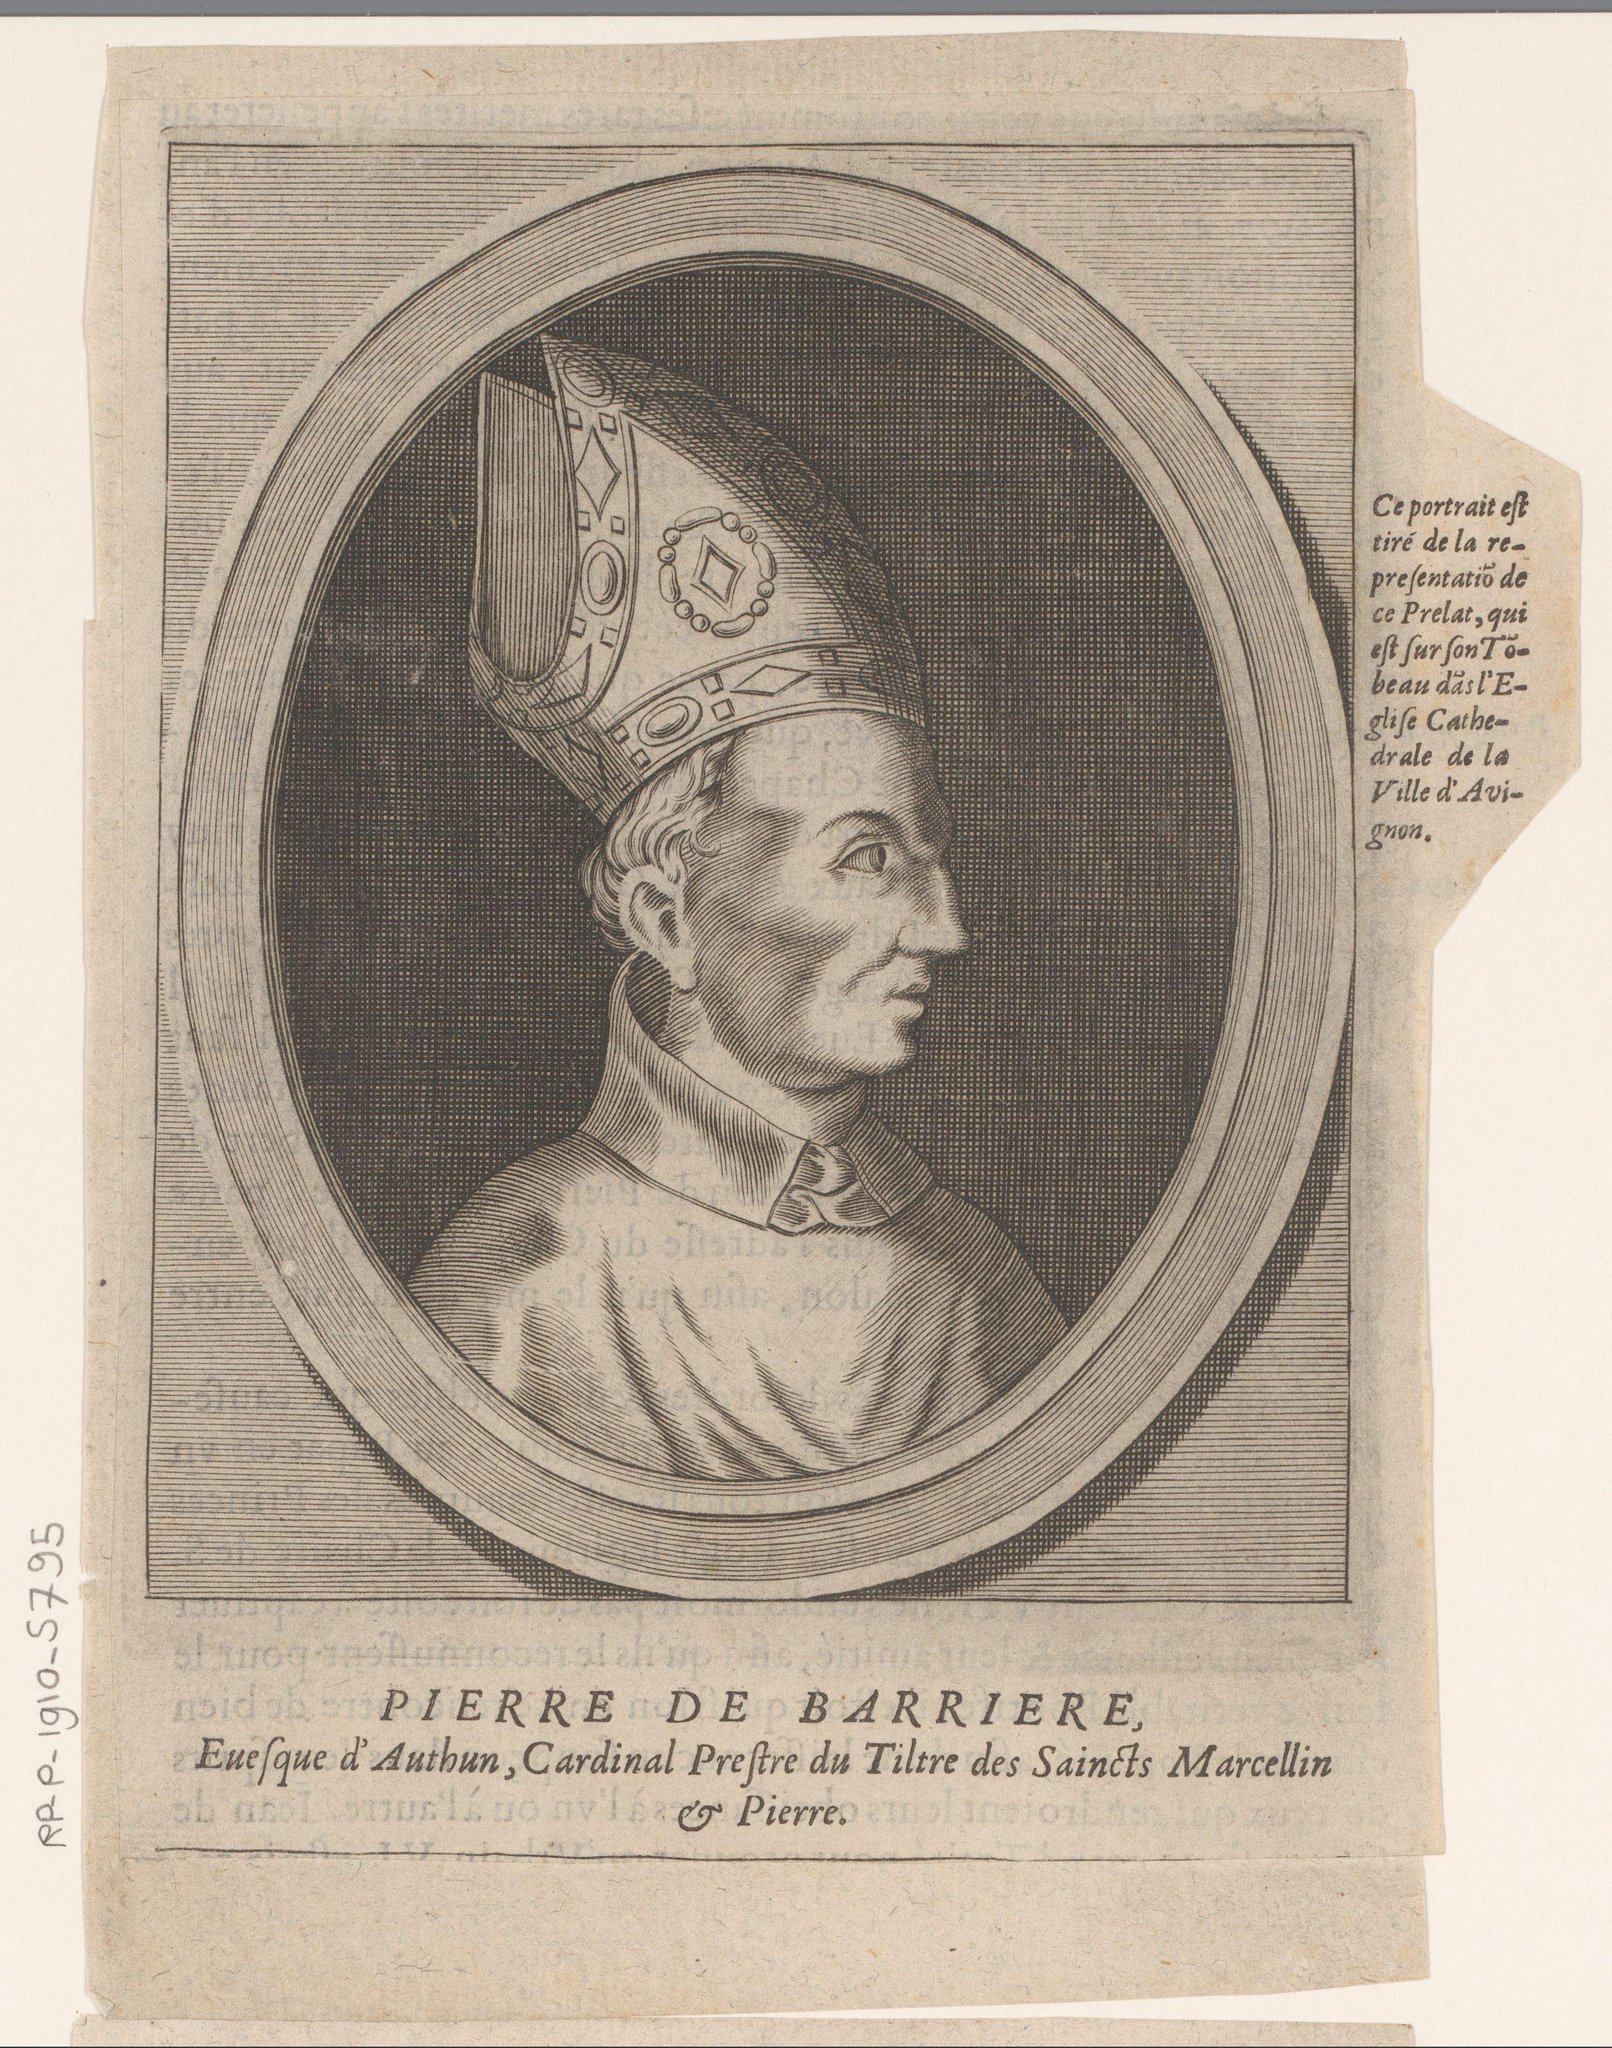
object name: book illustration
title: Pierre de Barriere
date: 1660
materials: paper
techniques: engraving, etching, letterpress printing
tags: archbishop, bishop, etc. (roman catholic), historical persons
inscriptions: collector's mark: Lugt 2228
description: Prent uit: Du Chesne, François. Histoire de tous les cardinaux françois de naissance, ou qui ont esté promeus au cardinalat. Parijs: François Du Chesne, 1660.